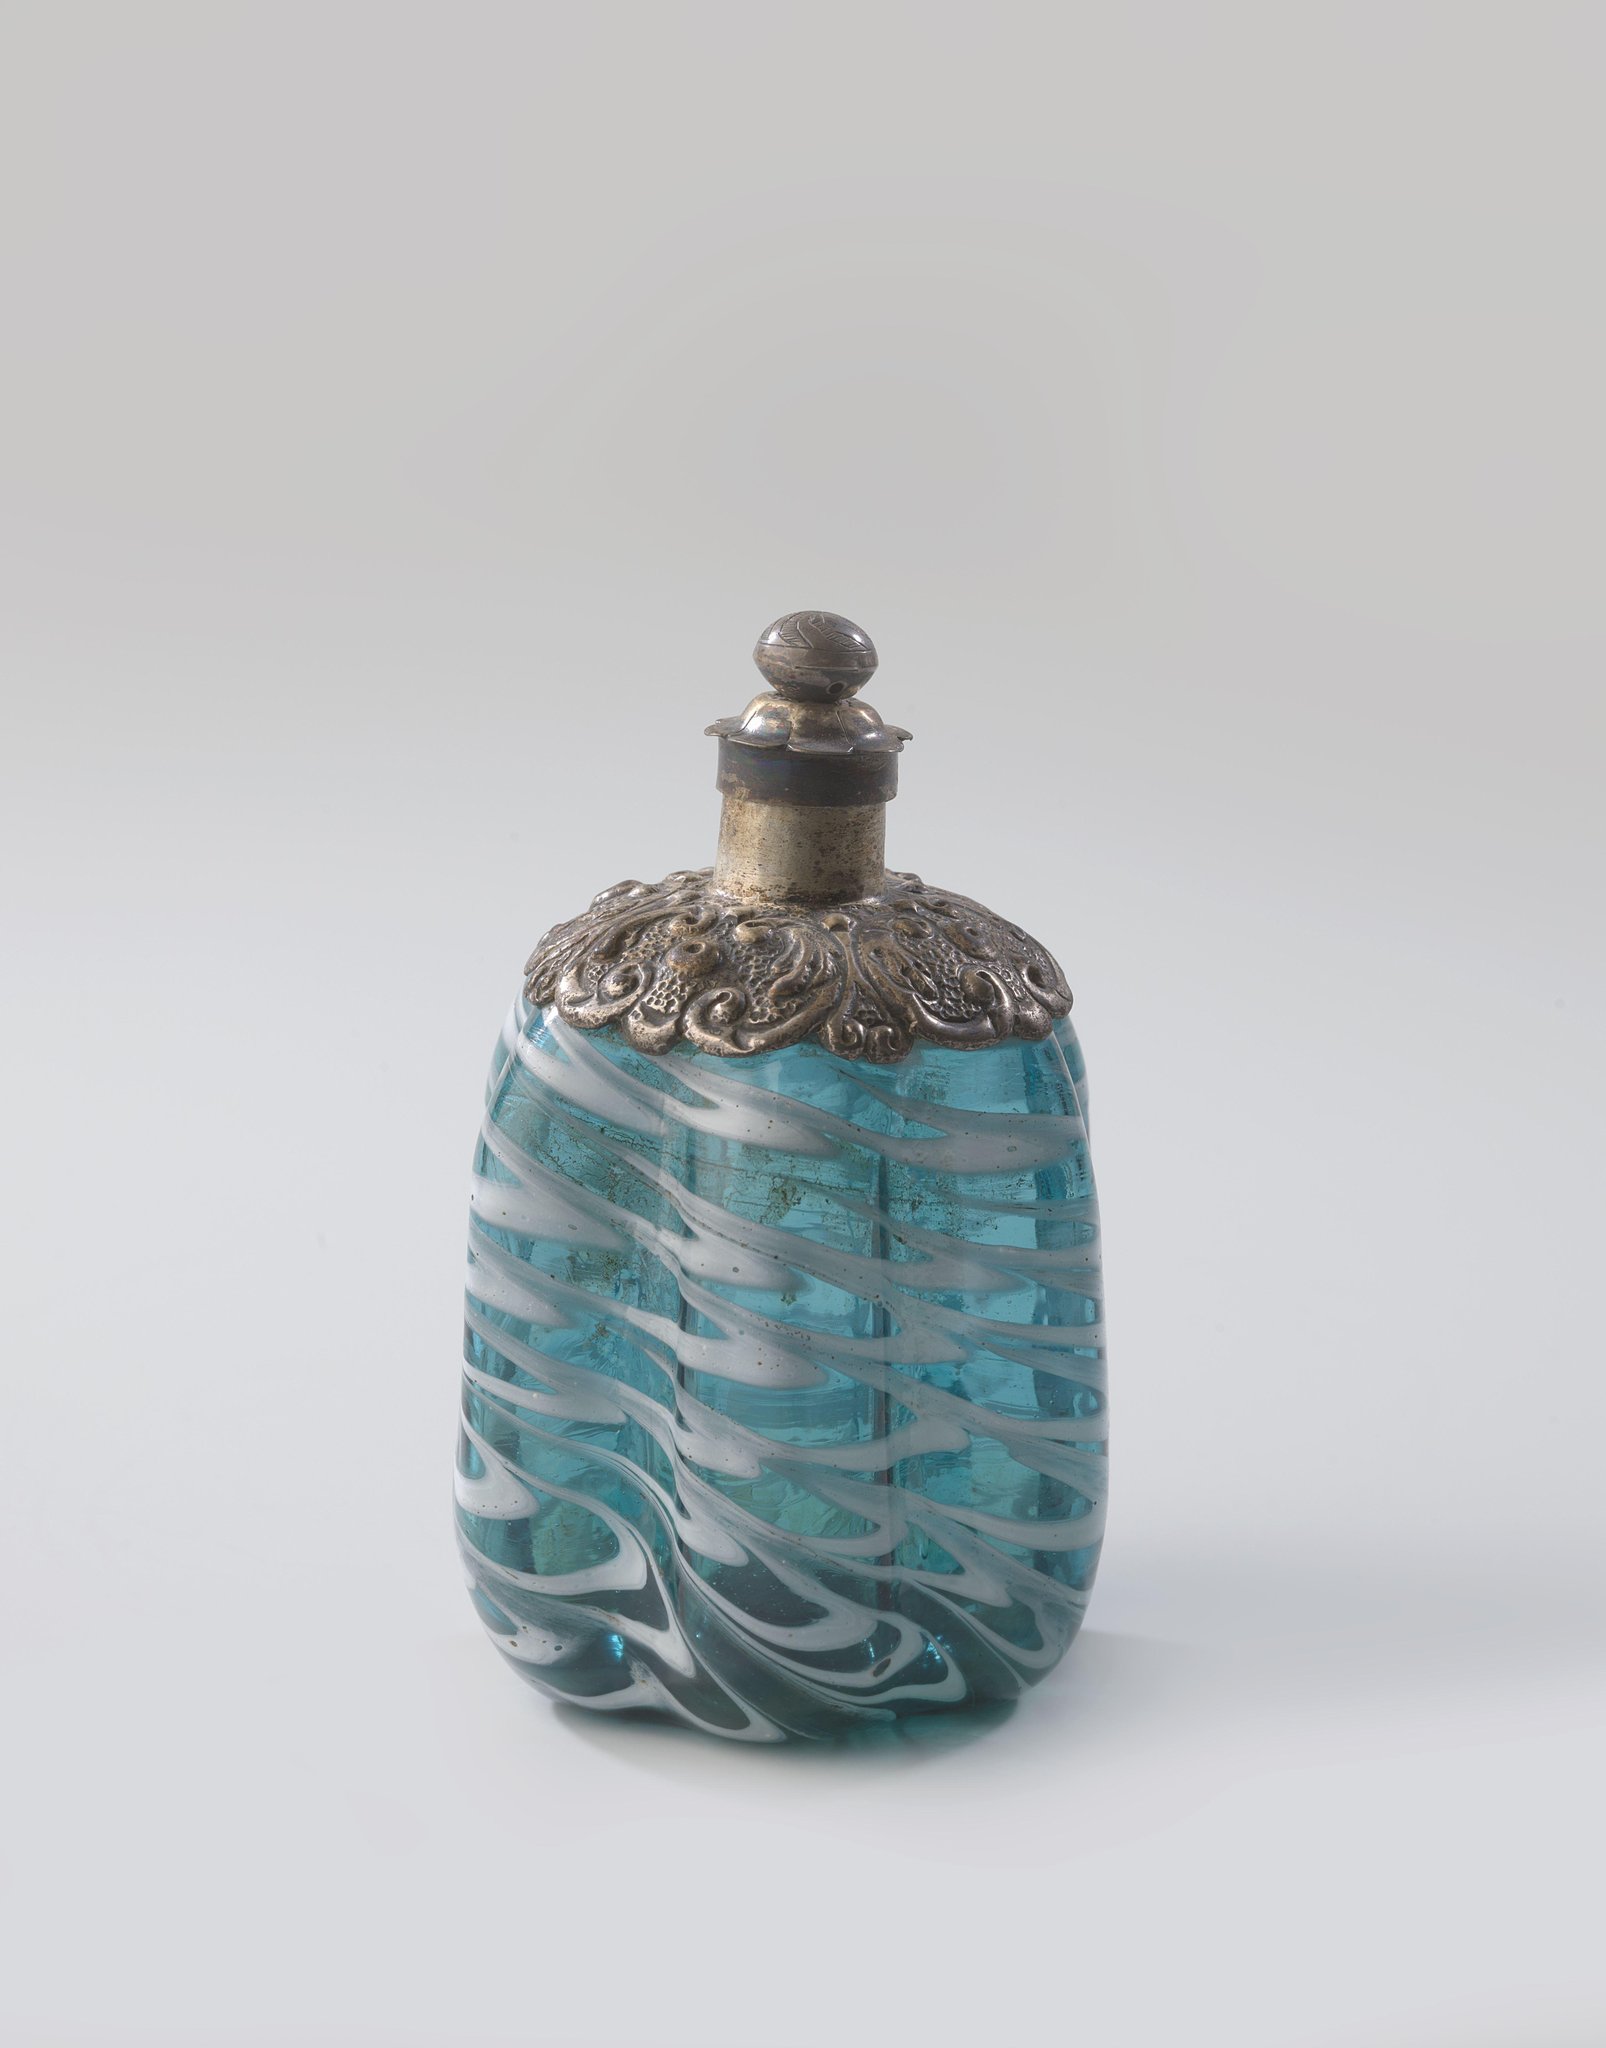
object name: flacon, flakon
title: Flacon met zes ribben in blauw met witte slierten, voorzien van zilveren monturen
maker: Anonymous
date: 1600-1700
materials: glass, silver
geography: venice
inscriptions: duty mark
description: Flacon van glas met zes ribben in blauw met witte slierten. Schouder, mondrand en deksel van zilver.